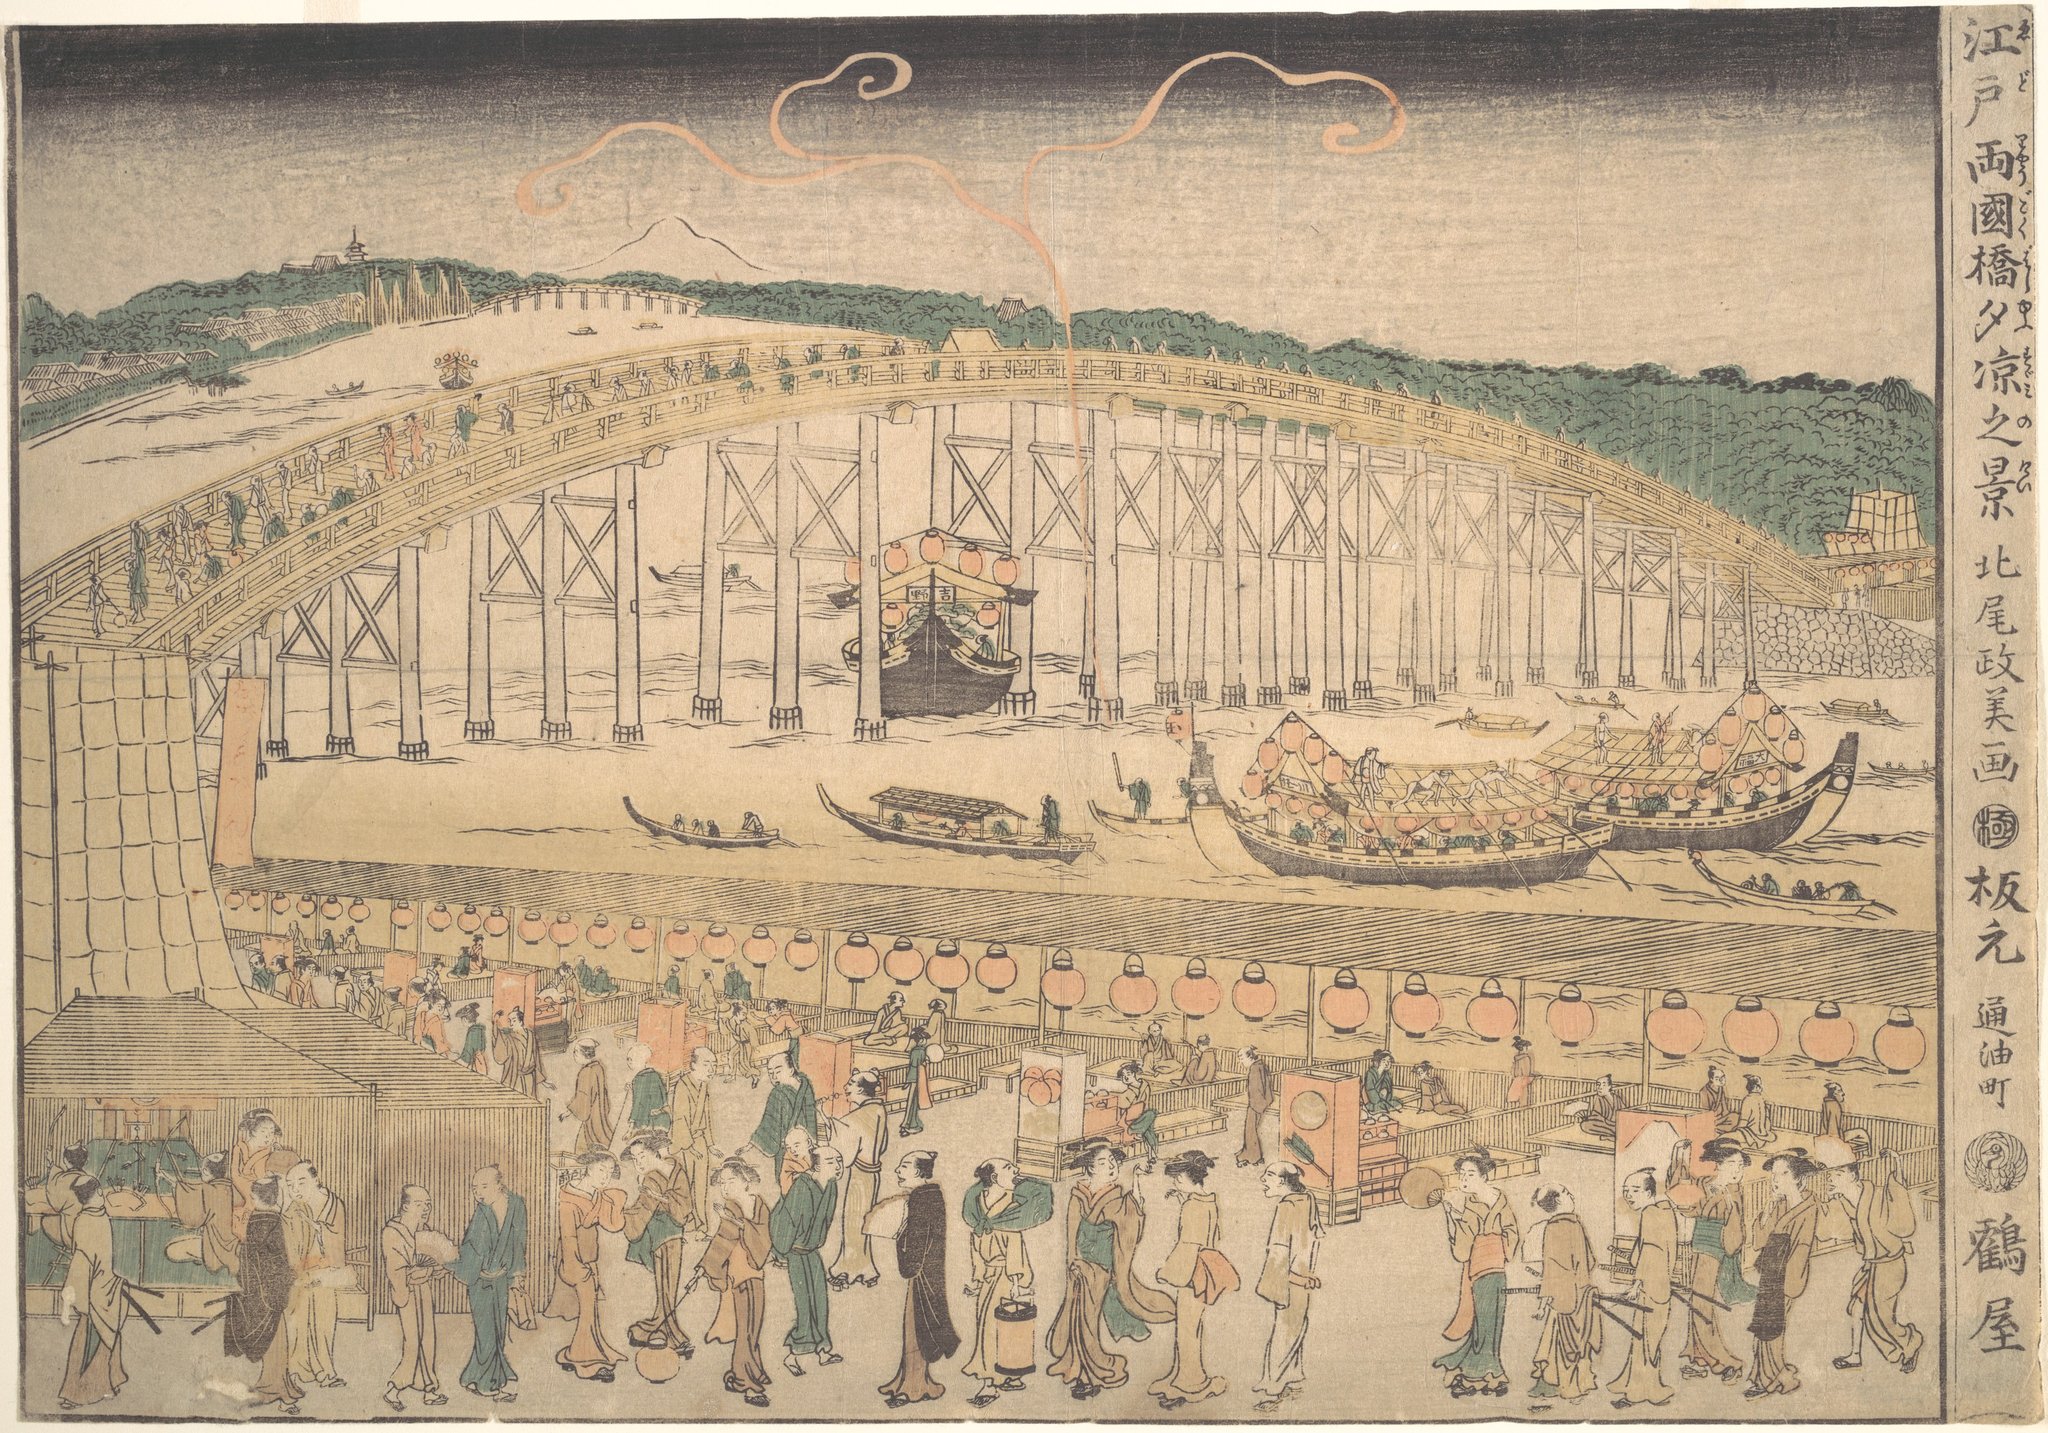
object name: print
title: Ryogoku Bridge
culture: japanese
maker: kuwagata keisai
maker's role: artist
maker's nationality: japanese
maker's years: 1764-1824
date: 1780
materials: ink, paper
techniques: woodblock print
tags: bridges,boats,lanterns,tea houses